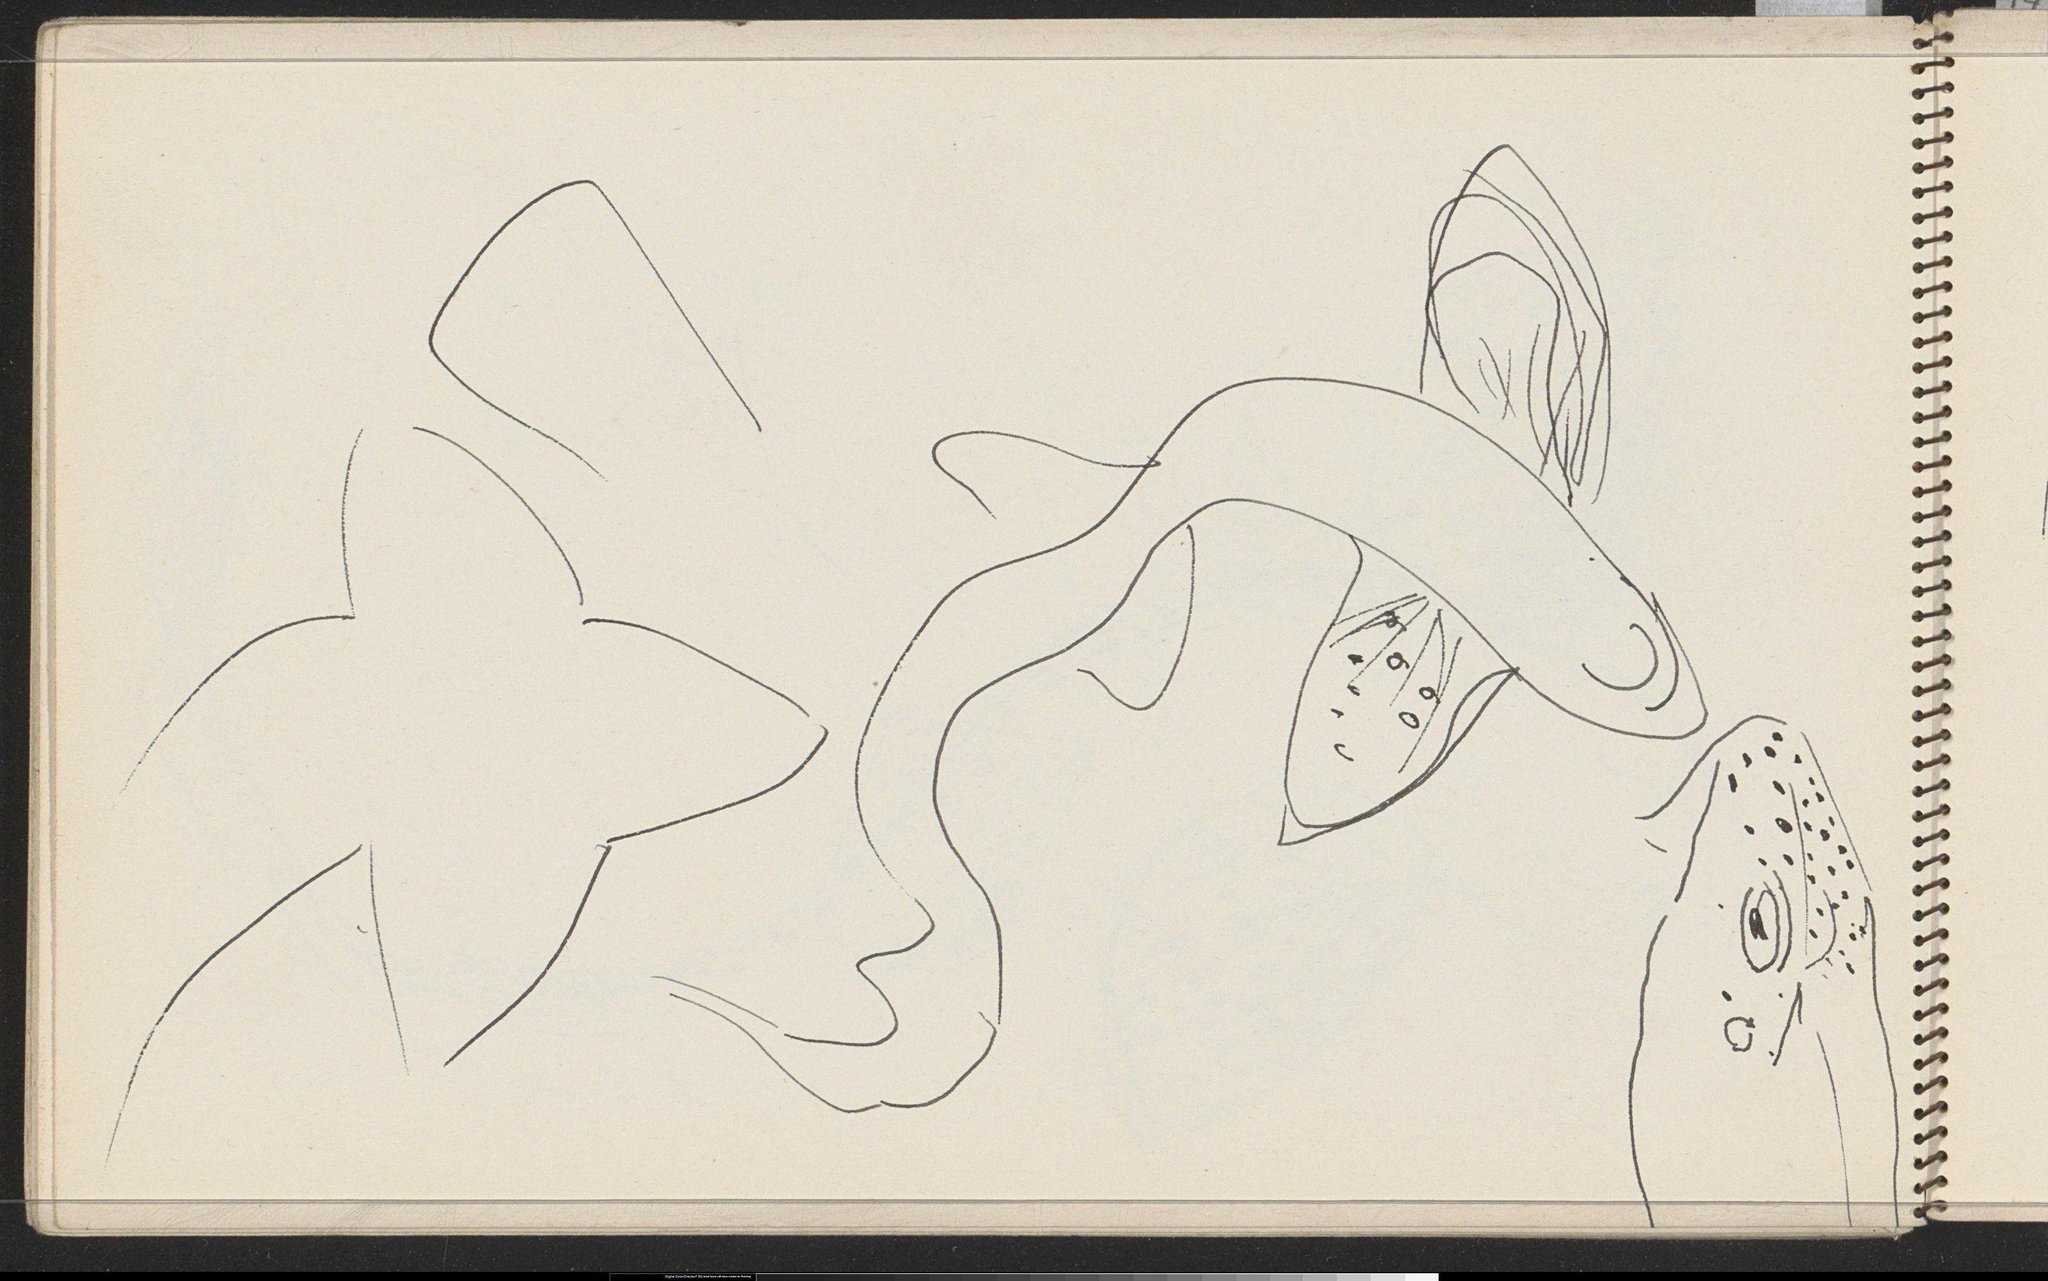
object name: sketchbook leaf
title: Vissen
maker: carel adolph lion cachet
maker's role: draughtsman, print maker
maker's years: 1864-1945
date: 1930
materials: ink, paper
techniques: pen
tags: fishes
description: Blad 12 verso uit een schetsboek met 20 bladen.